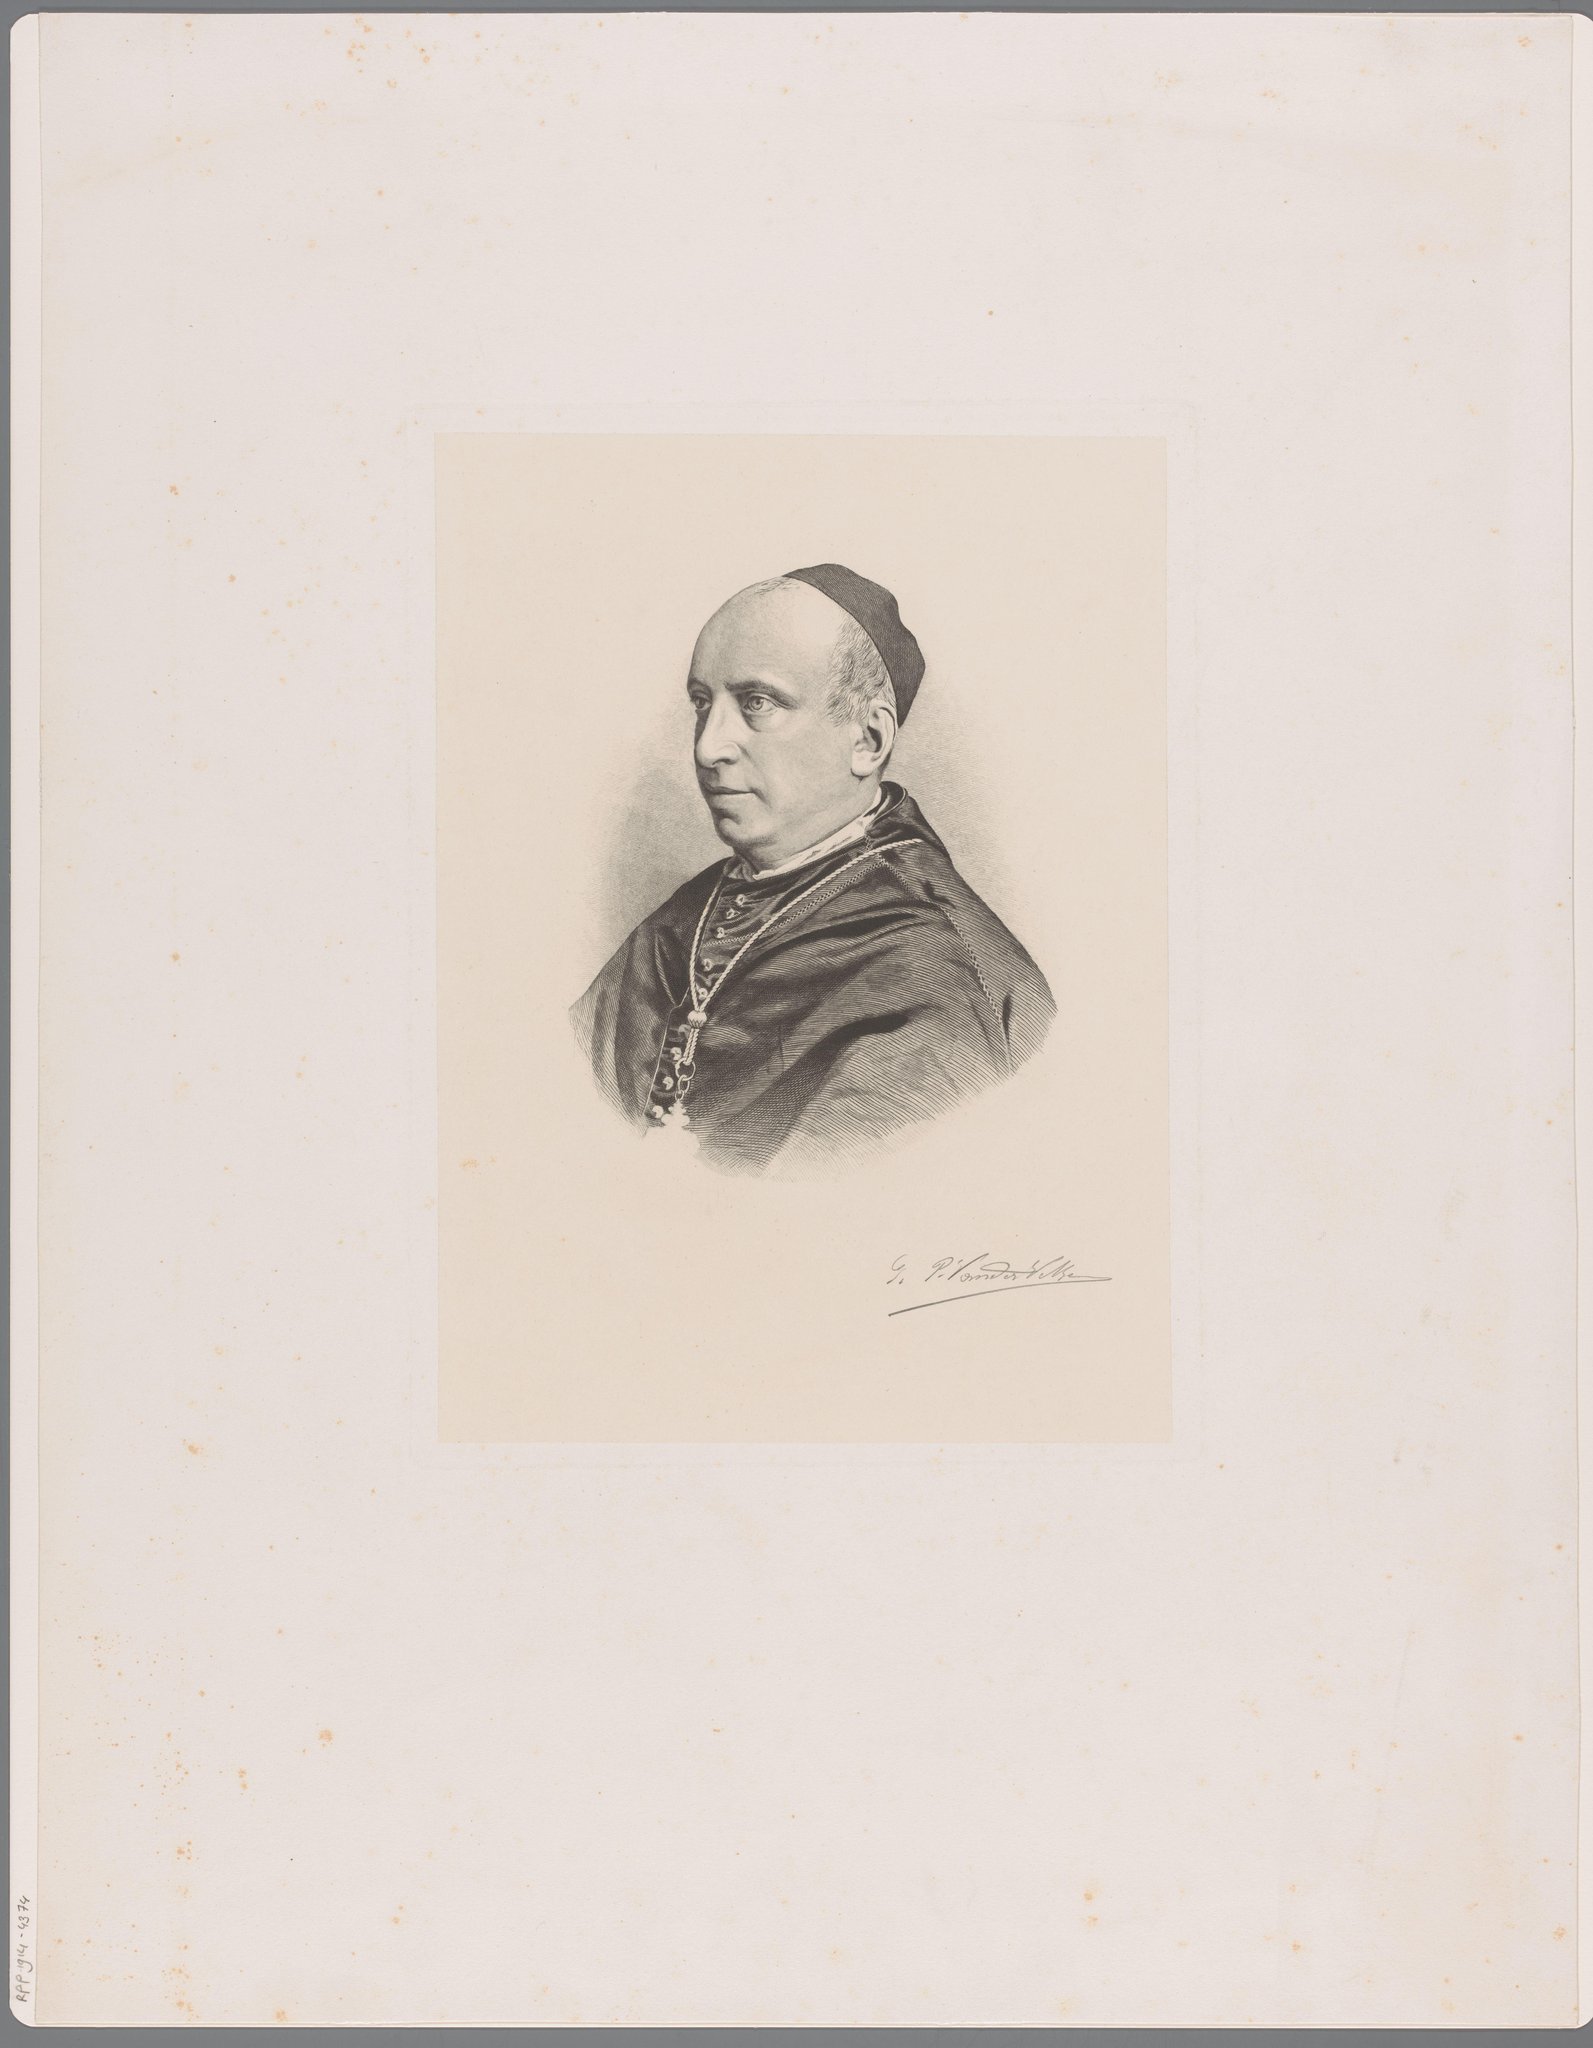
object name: print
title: Portret van kanunnik Alphonse de Leyn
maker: willem philip van der veken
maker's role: print maker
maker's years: 1863-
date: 1873-1914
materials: paper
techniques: etching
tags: adult man, historical persons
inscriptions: collector's mark: Lugt 2228